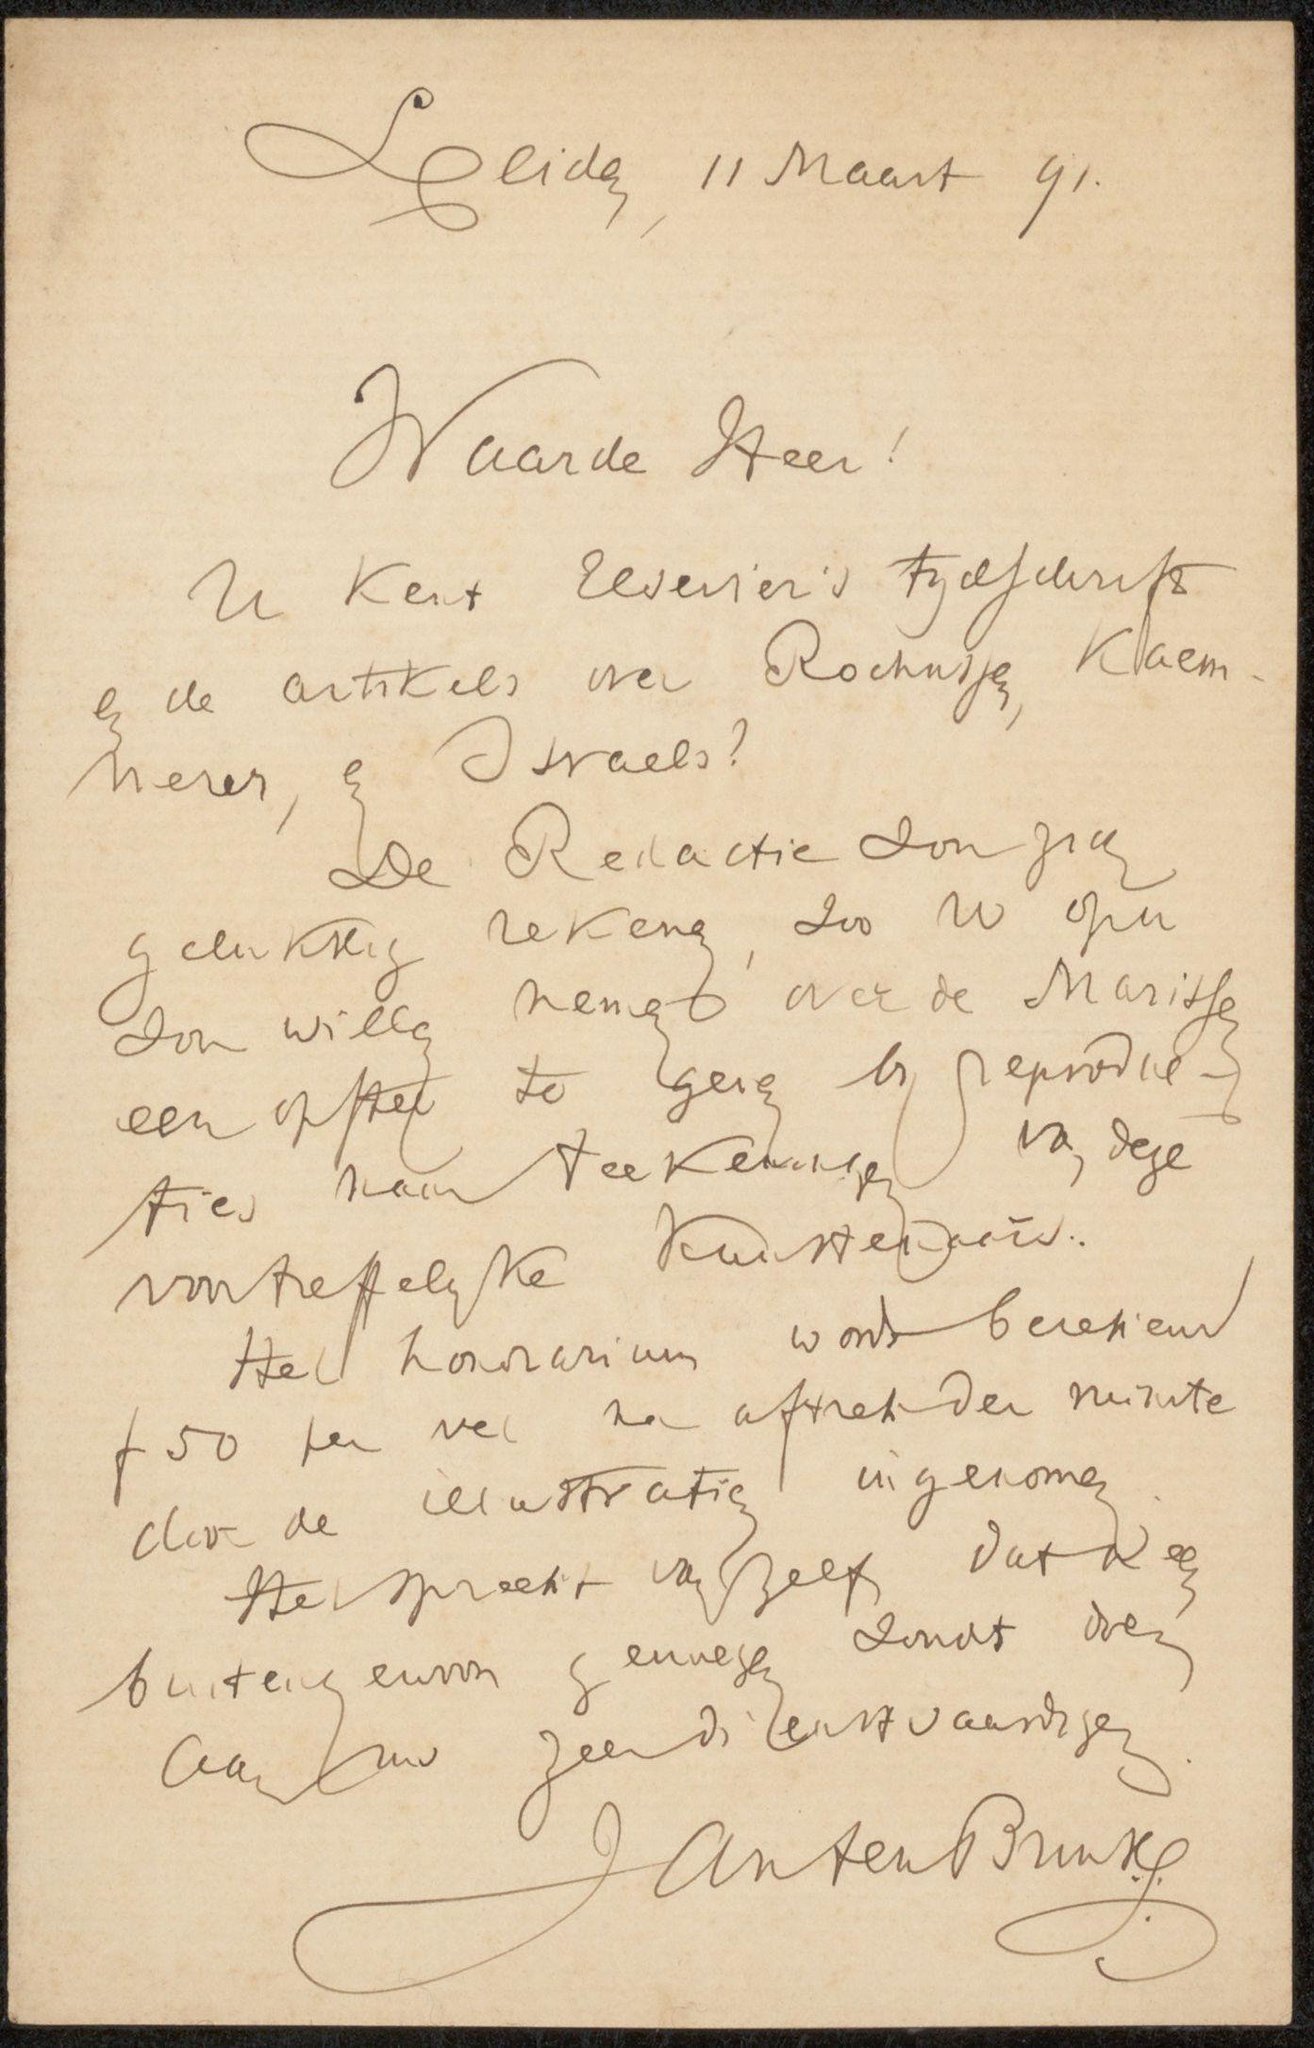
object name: letter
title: Brief aan Philip Zilcken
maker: jan ten brink (1834-1901)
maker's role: prozaschrijver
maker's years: 1834-1901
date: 1891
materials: ink, paper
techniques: pen, writing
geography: leiden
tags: rotterdam, charles rochussen, print maker, jozef israëls, frederik hendrik kaemmerer, the hague, painter, draughtsman, philip zilcken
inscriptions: name: ‘Dr. J. ten Brink’, collector's mark: ‘RPK’, watermark: ‘Ch/ EXTRA DÜREN’